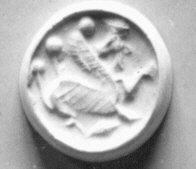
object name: stamp seal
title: Stamp seal (scaraboid) with monster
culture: urartian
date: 900-601 BCE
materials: limestone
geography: syria or anatolia